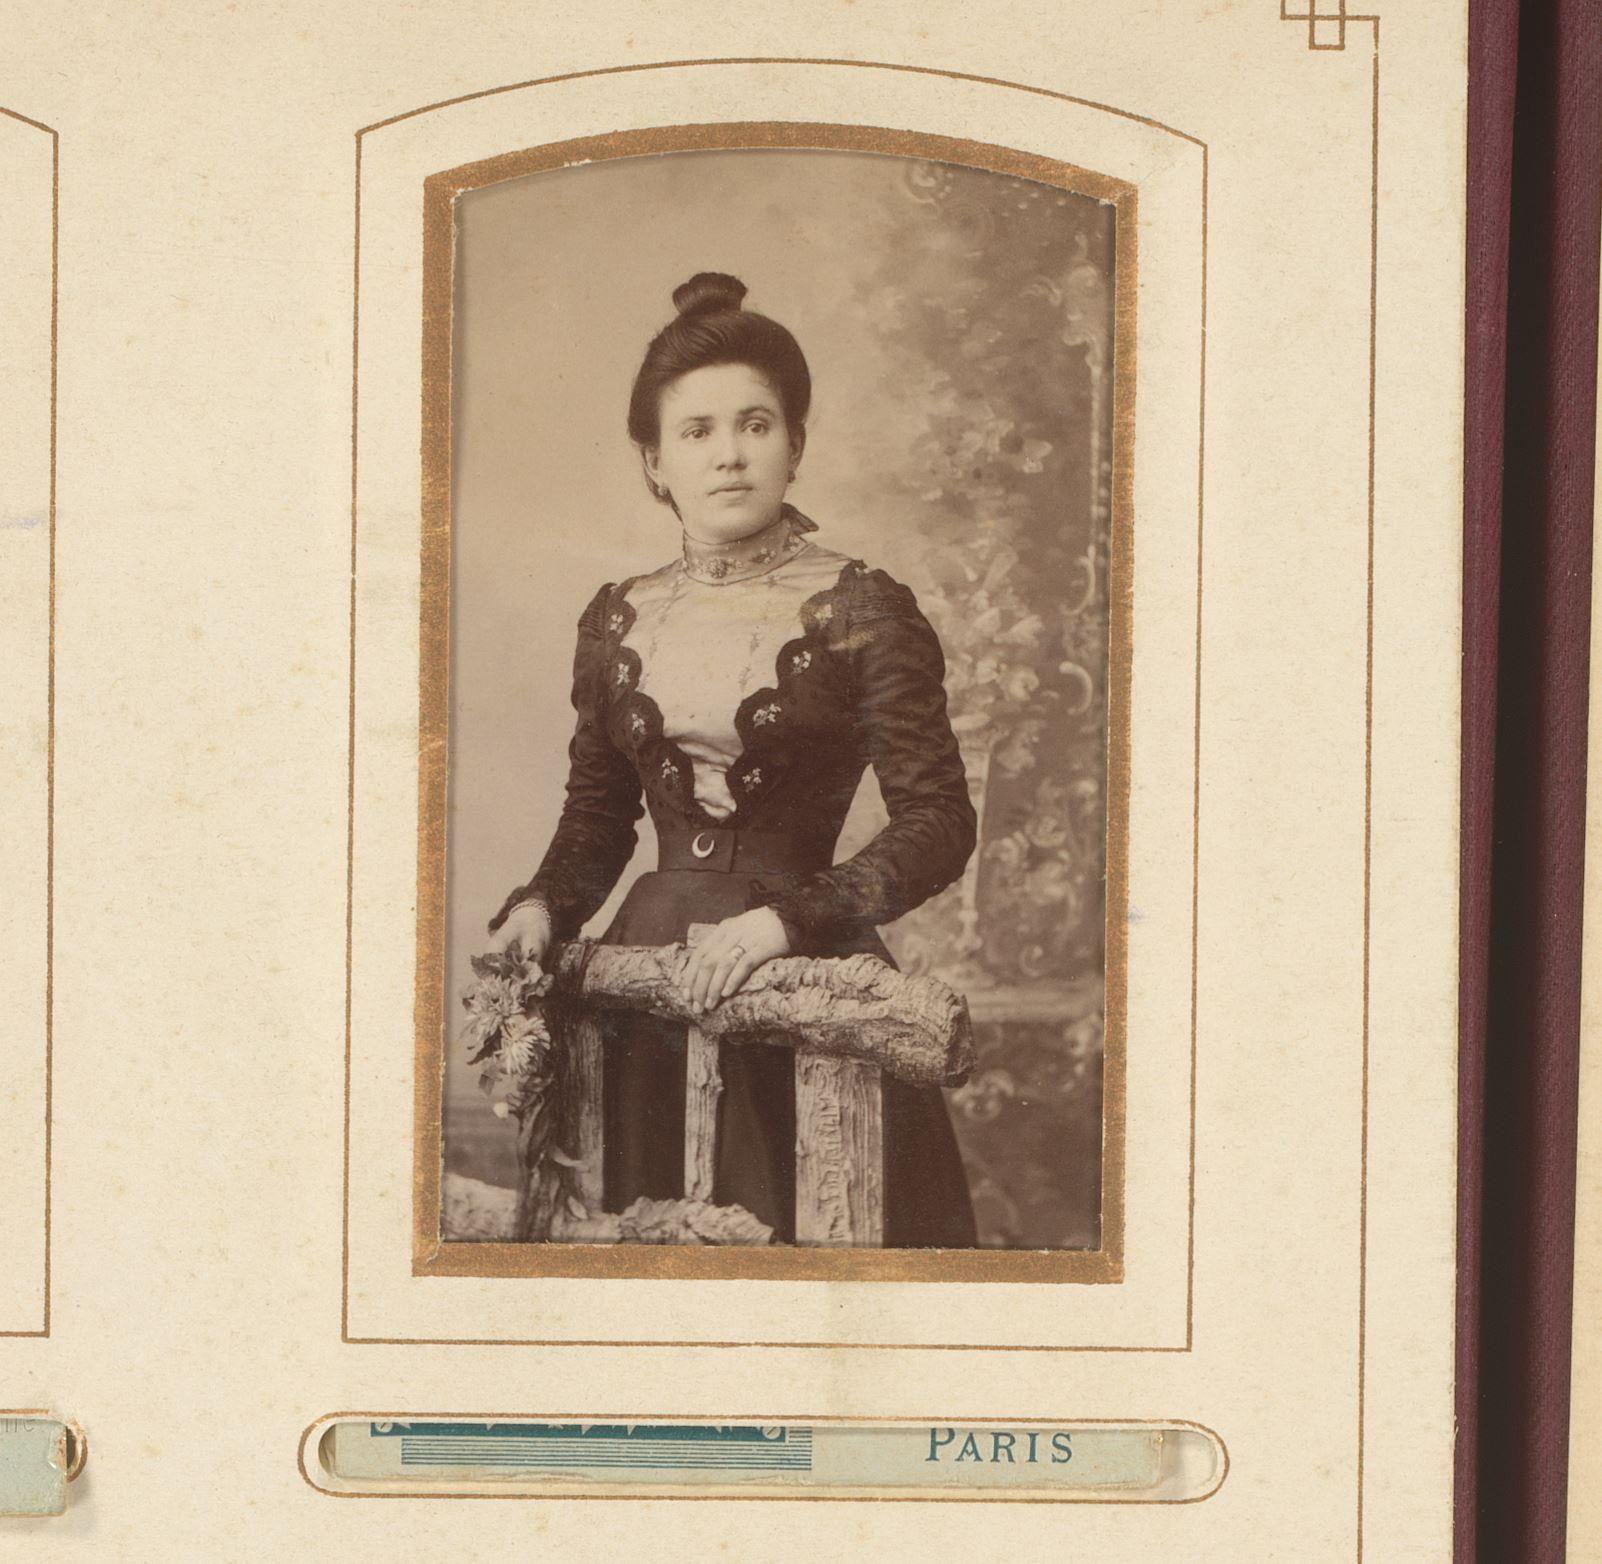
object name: album leaf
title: Portret van een jonge vrouw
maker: petrus monroche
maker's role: fotograaf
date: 1860-1900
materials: cardboard, photographic support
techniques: albumen print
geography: paris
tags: historical persons - bb - woman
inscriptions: inscription: ‘Petrus Monroche/ 110, Rue St. Antoine/ Paris’